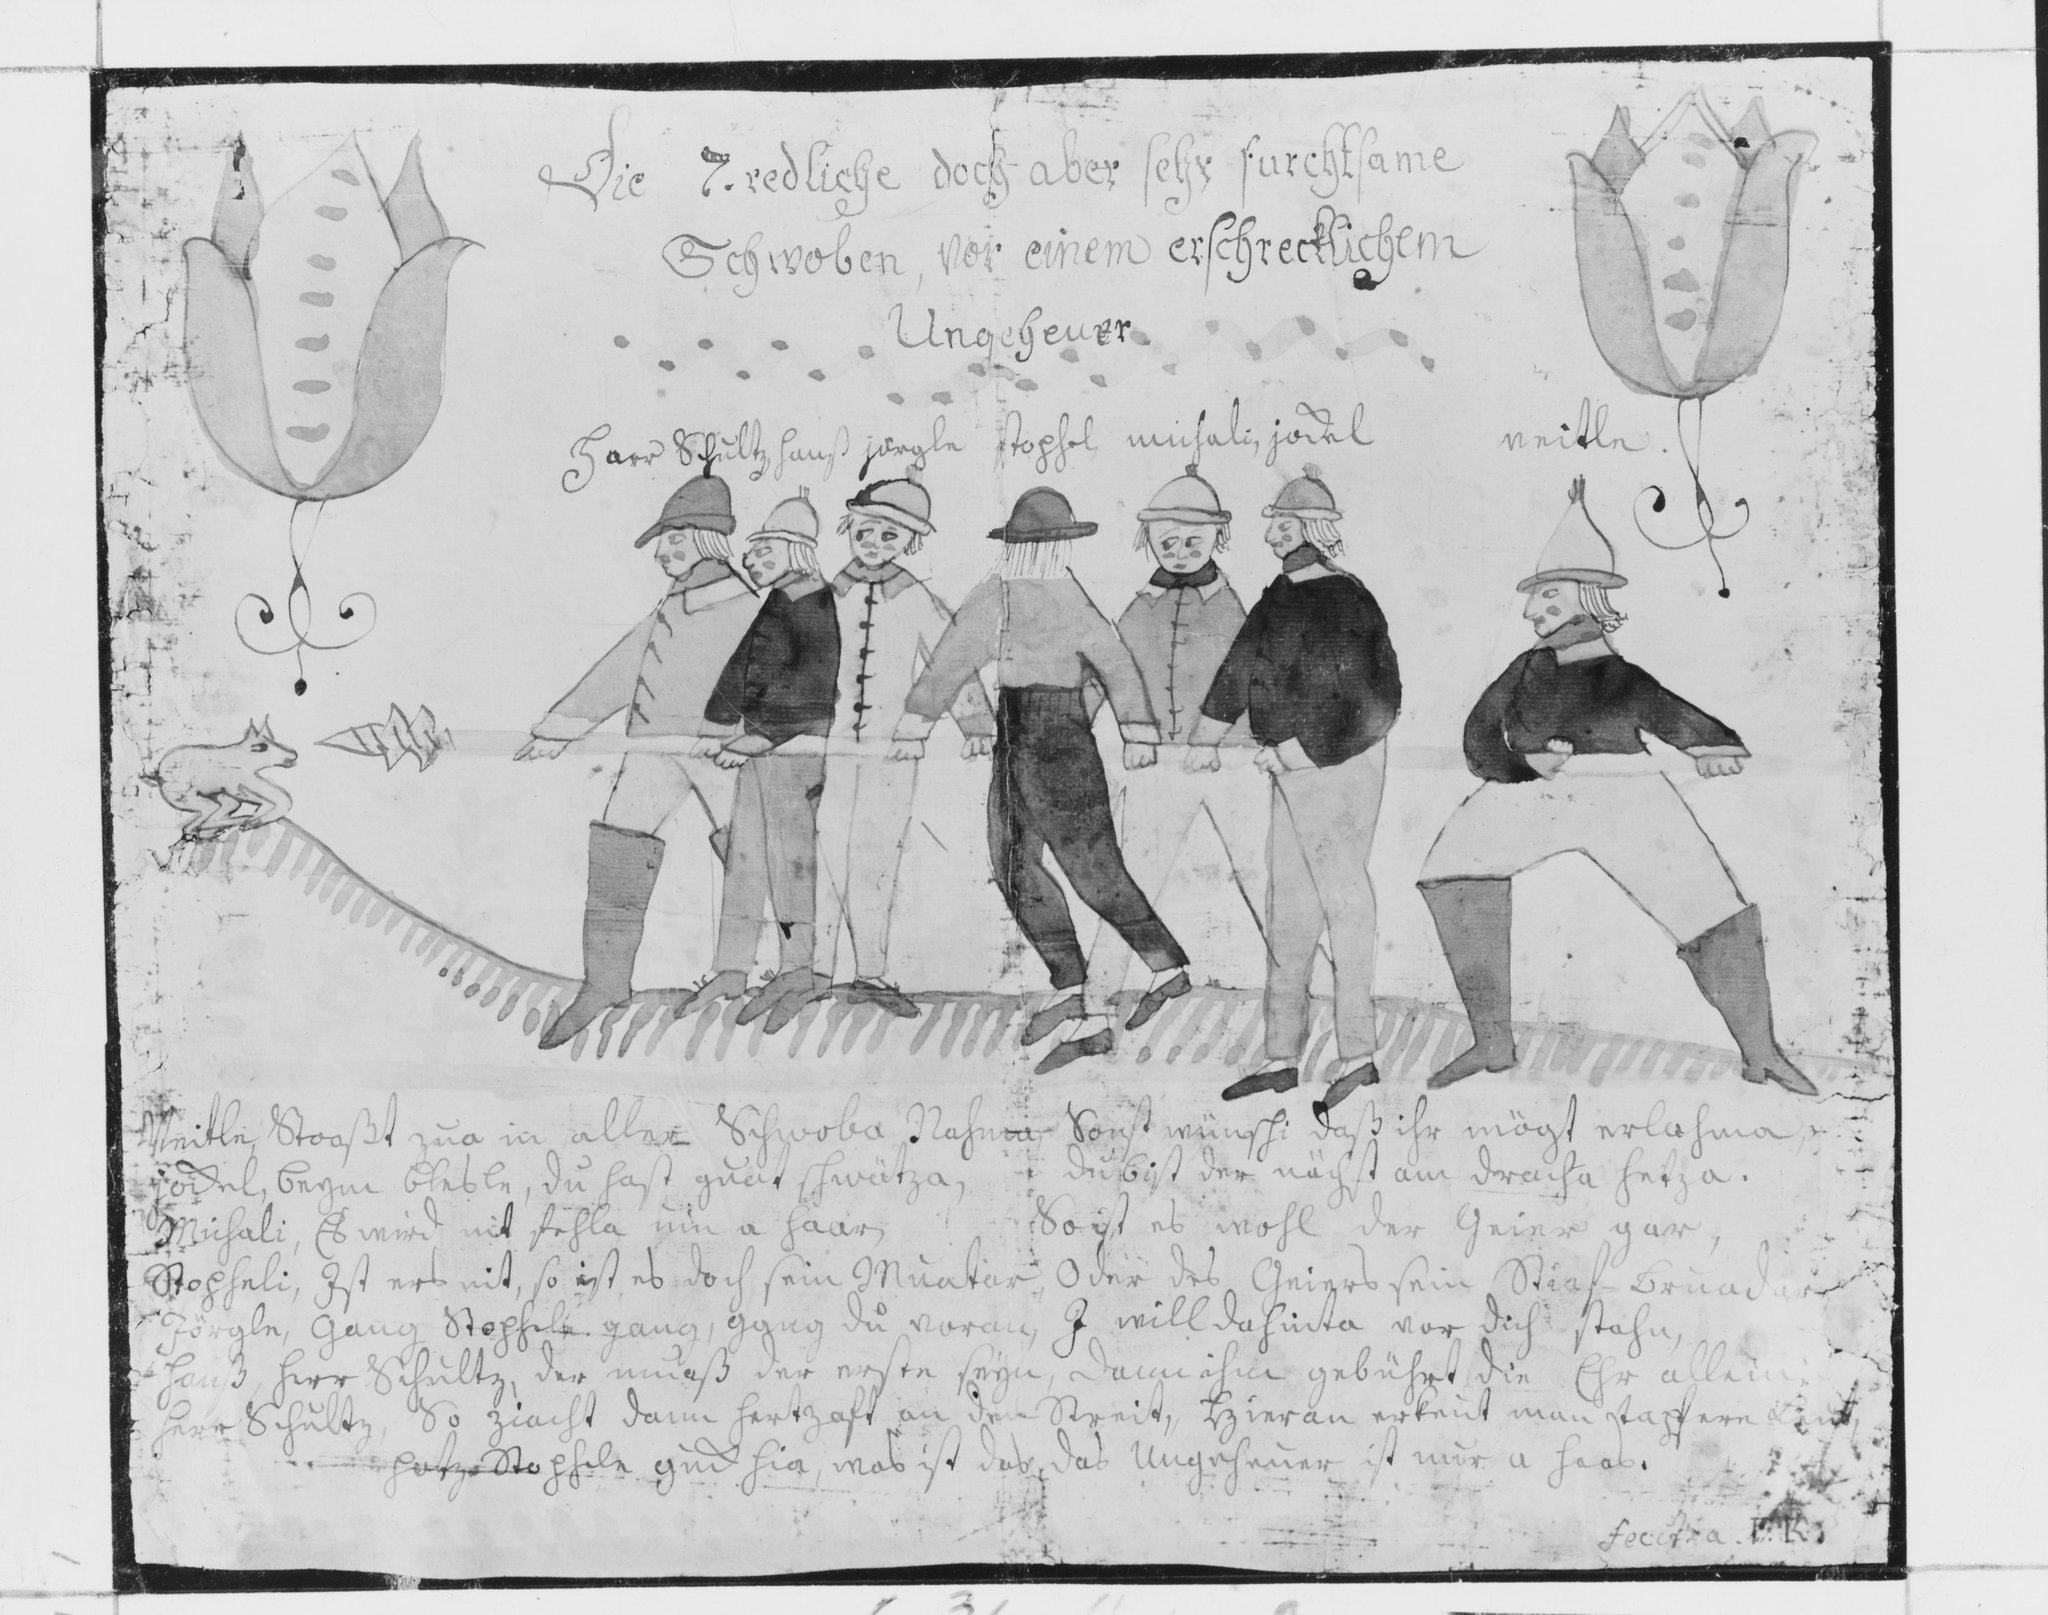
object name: drawing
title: Drawing of a Hunt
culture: american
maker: friederich krebs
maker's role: maker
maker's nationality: american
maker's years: 1765-1815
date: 1800-1830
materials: paper, watercolor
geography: united states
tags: animals,men,hunting,tulips